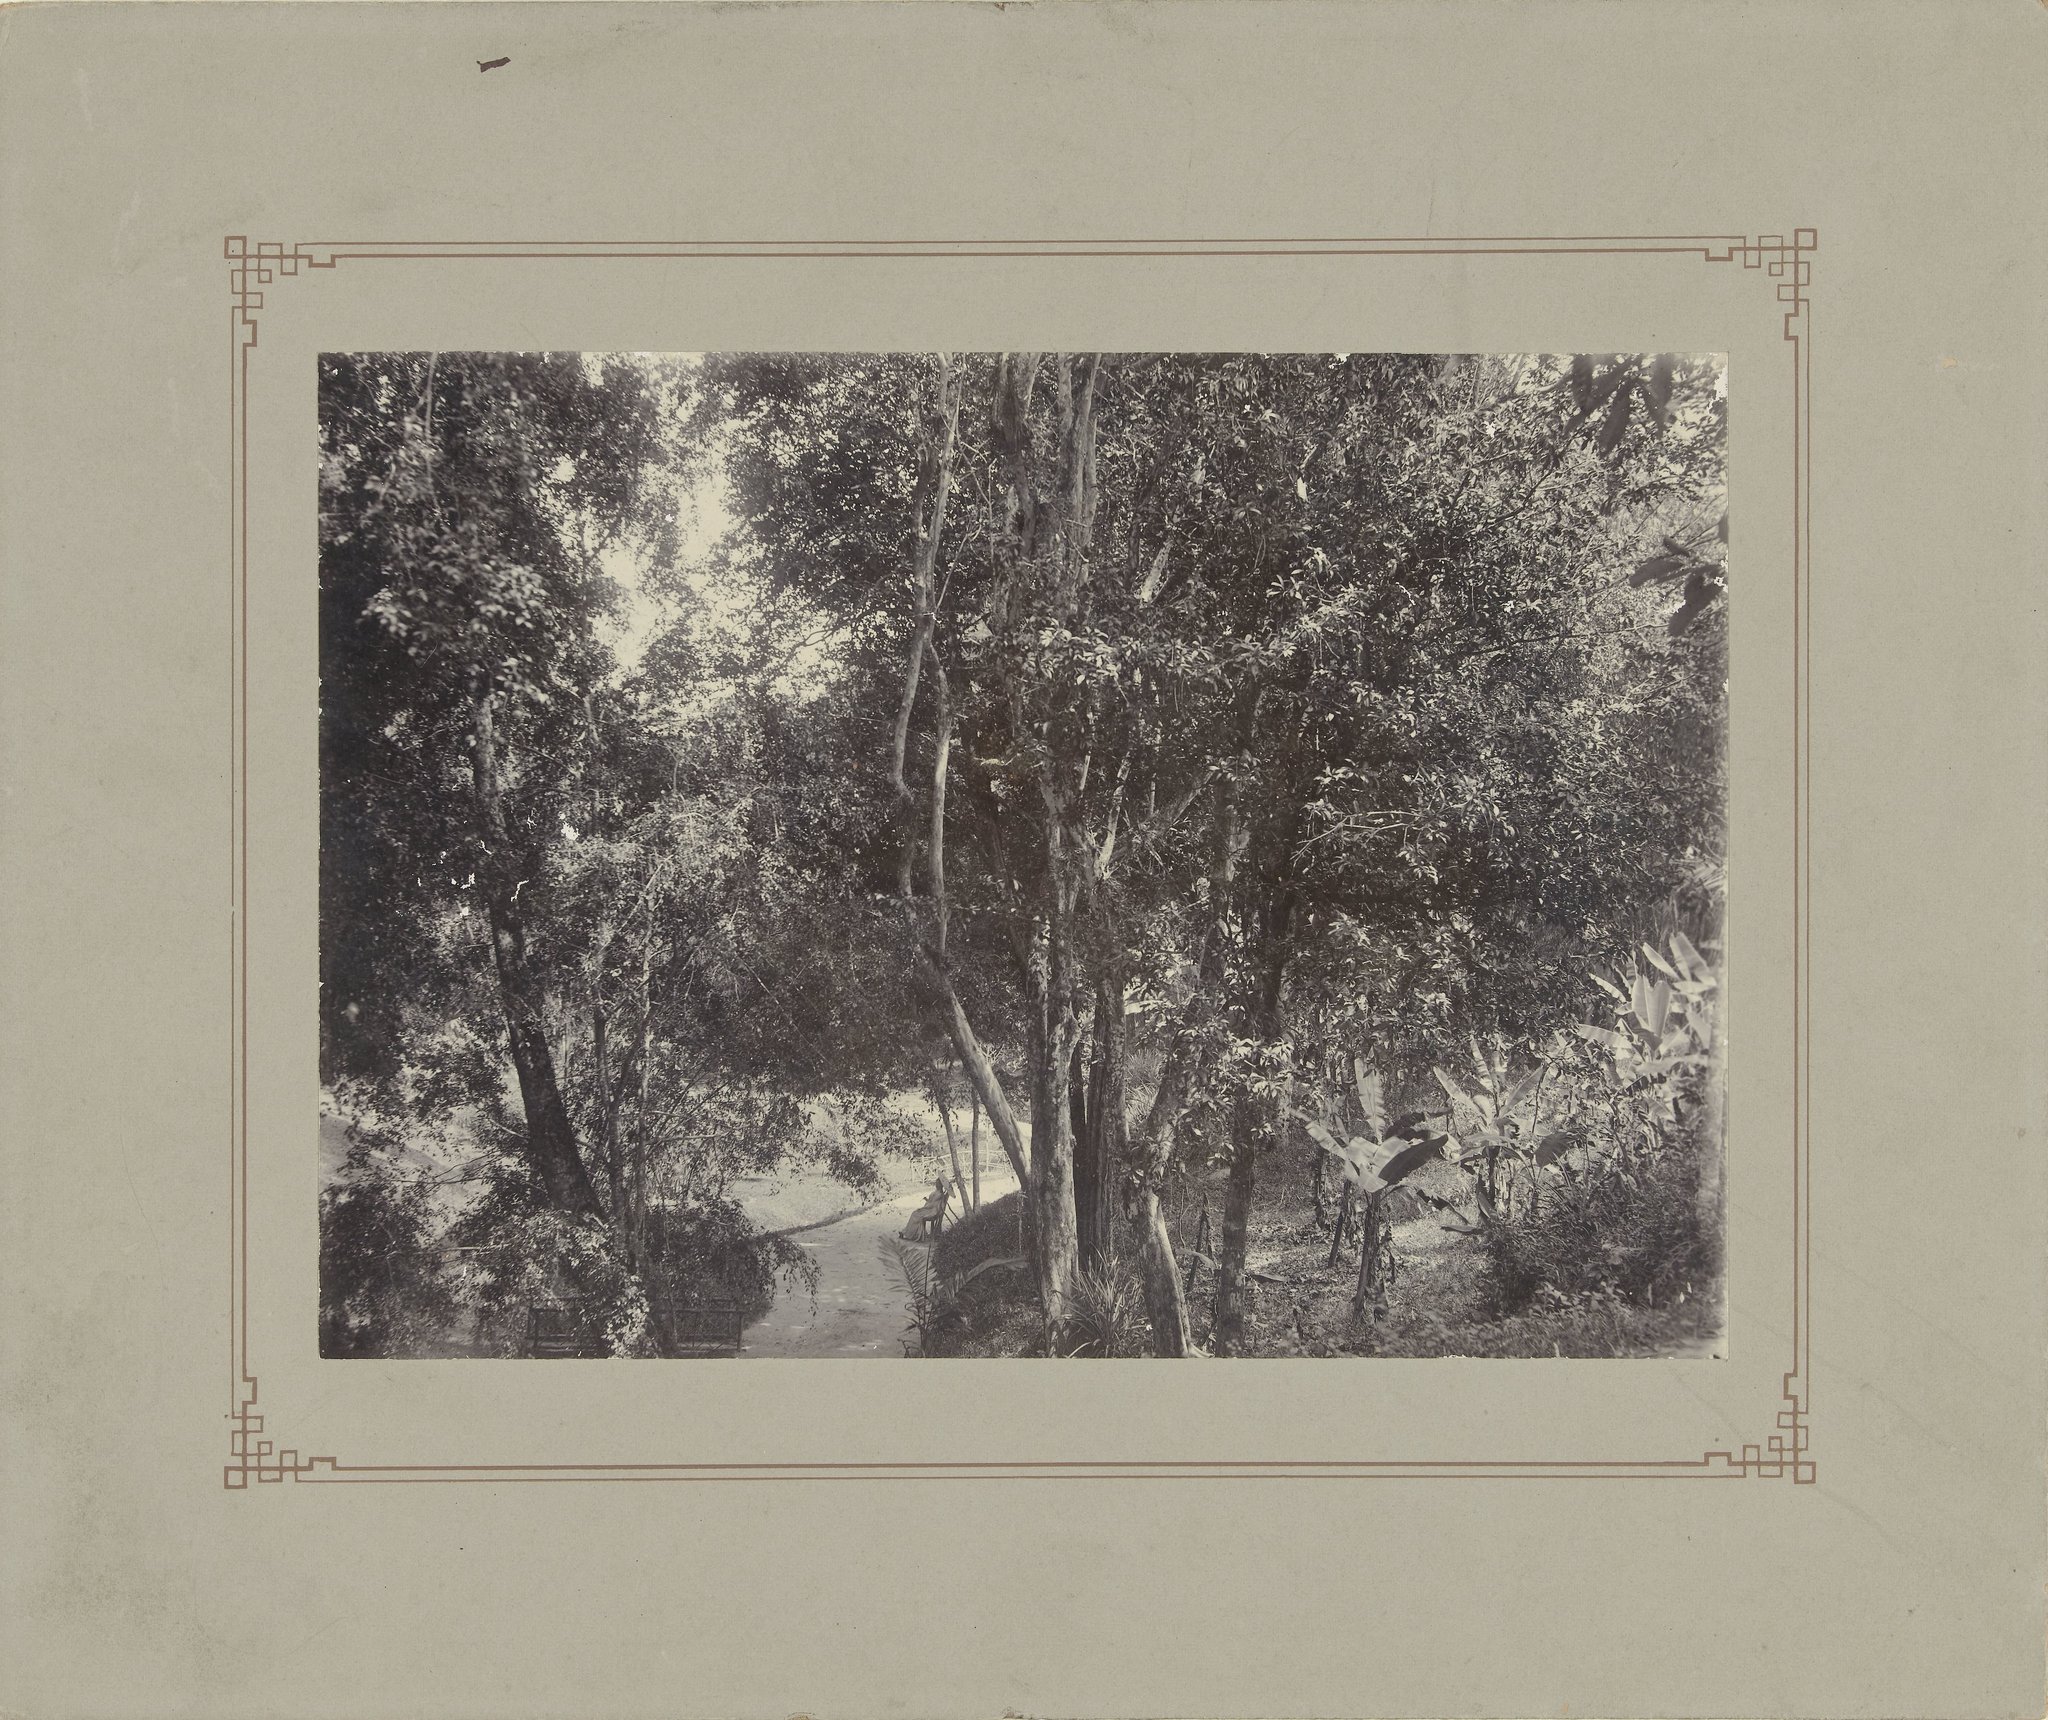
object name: photograph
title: Portret van een vrouw met parasol op een stoel in Nederlands-Indië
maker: Anonymous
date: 1890-1920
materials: paper, cardboard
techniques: gelatin silver print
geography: dutch east indies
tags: park, trees, historical persons, forest, wood, parasol, sunshade, dutch east indies, the